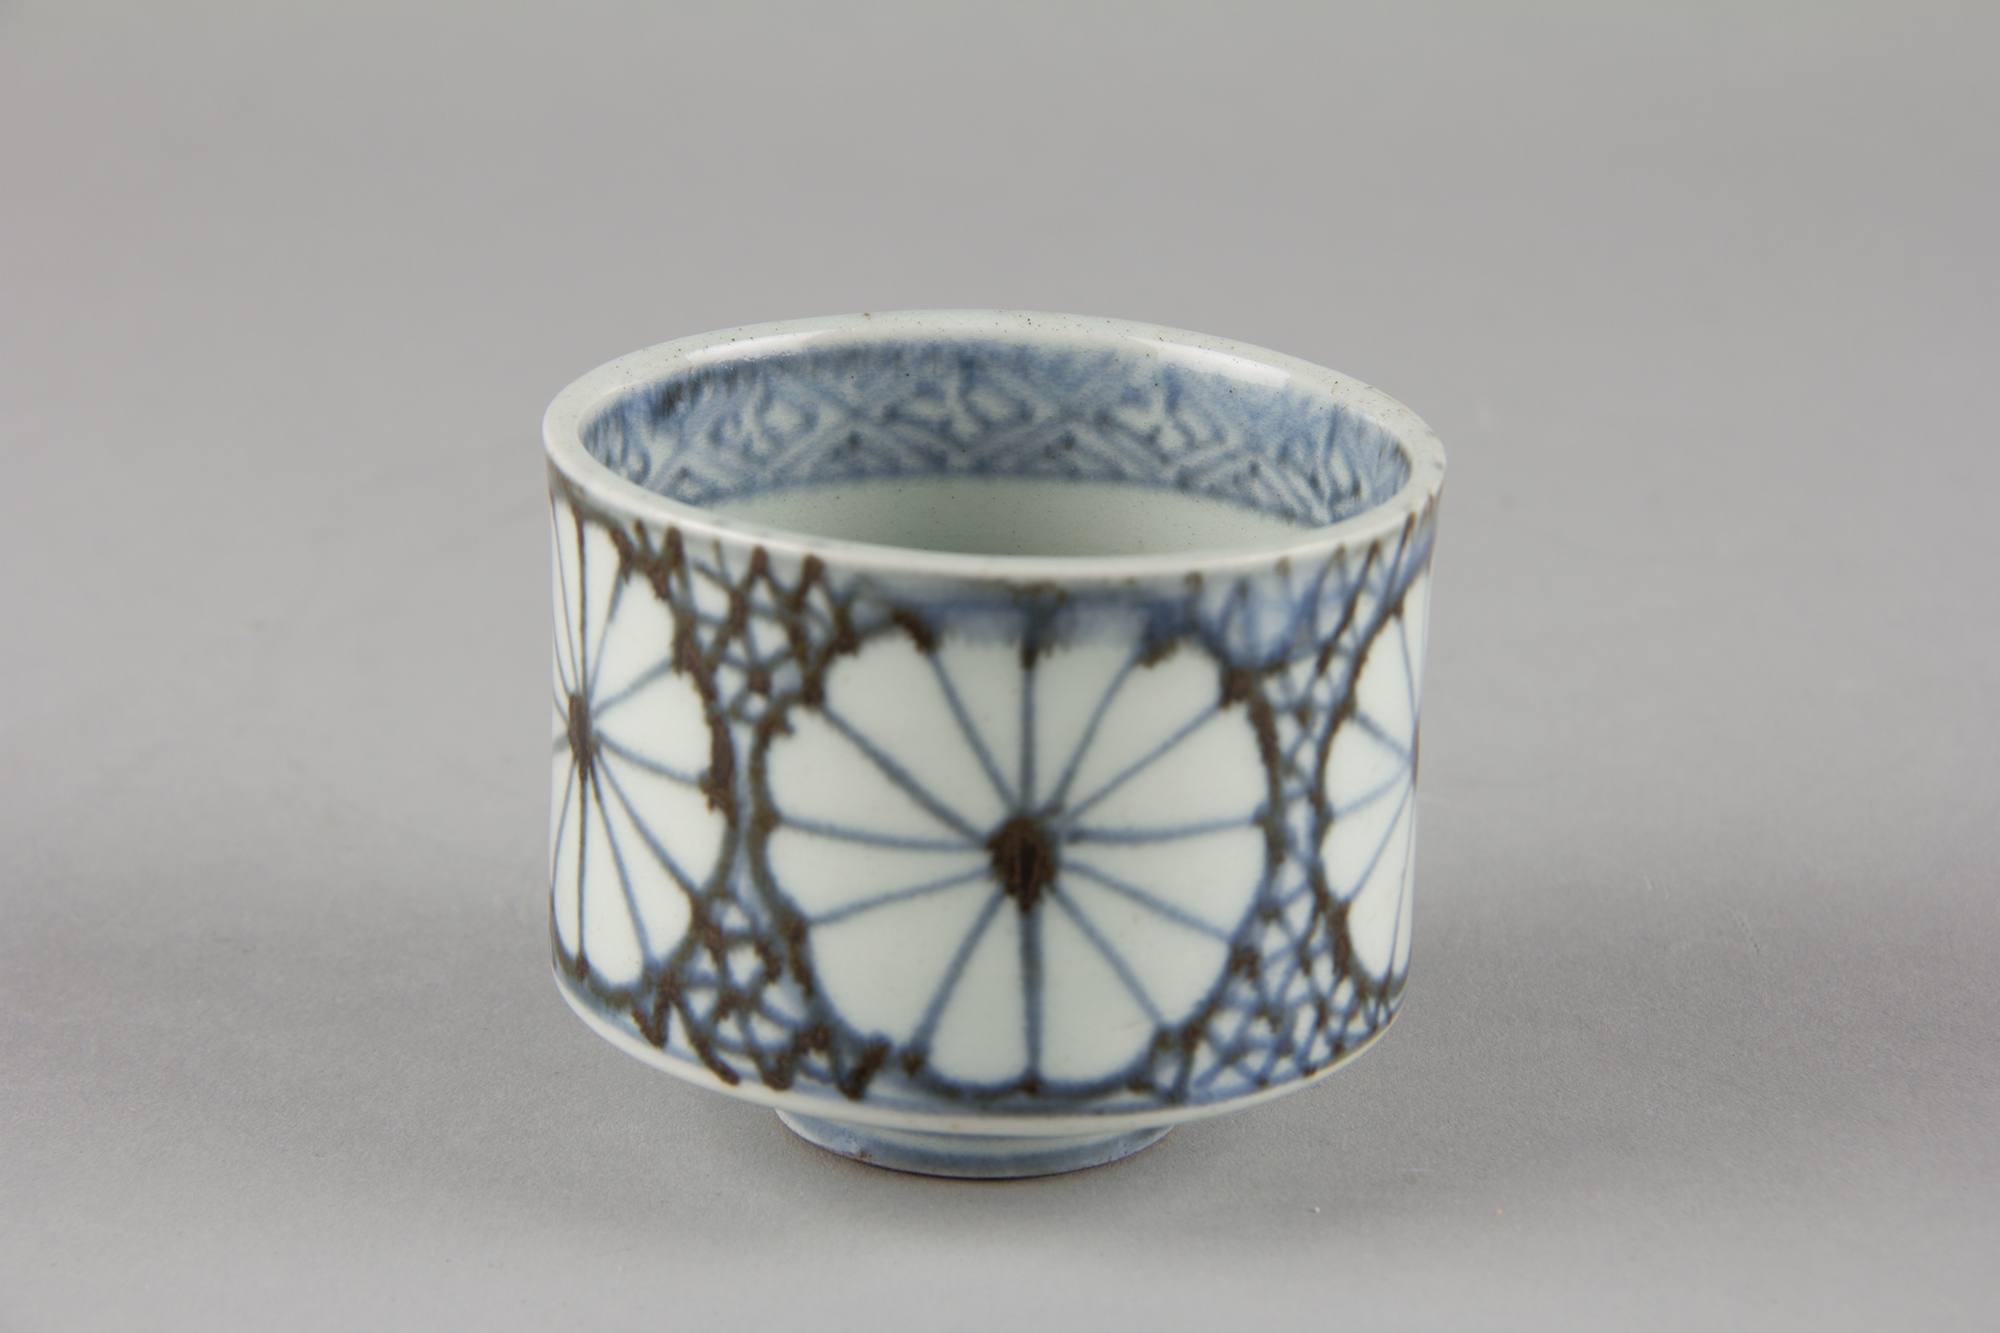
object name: soba cup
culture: japanese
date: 1801-1900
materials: cobalt, porcelain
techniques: painting, underglaze